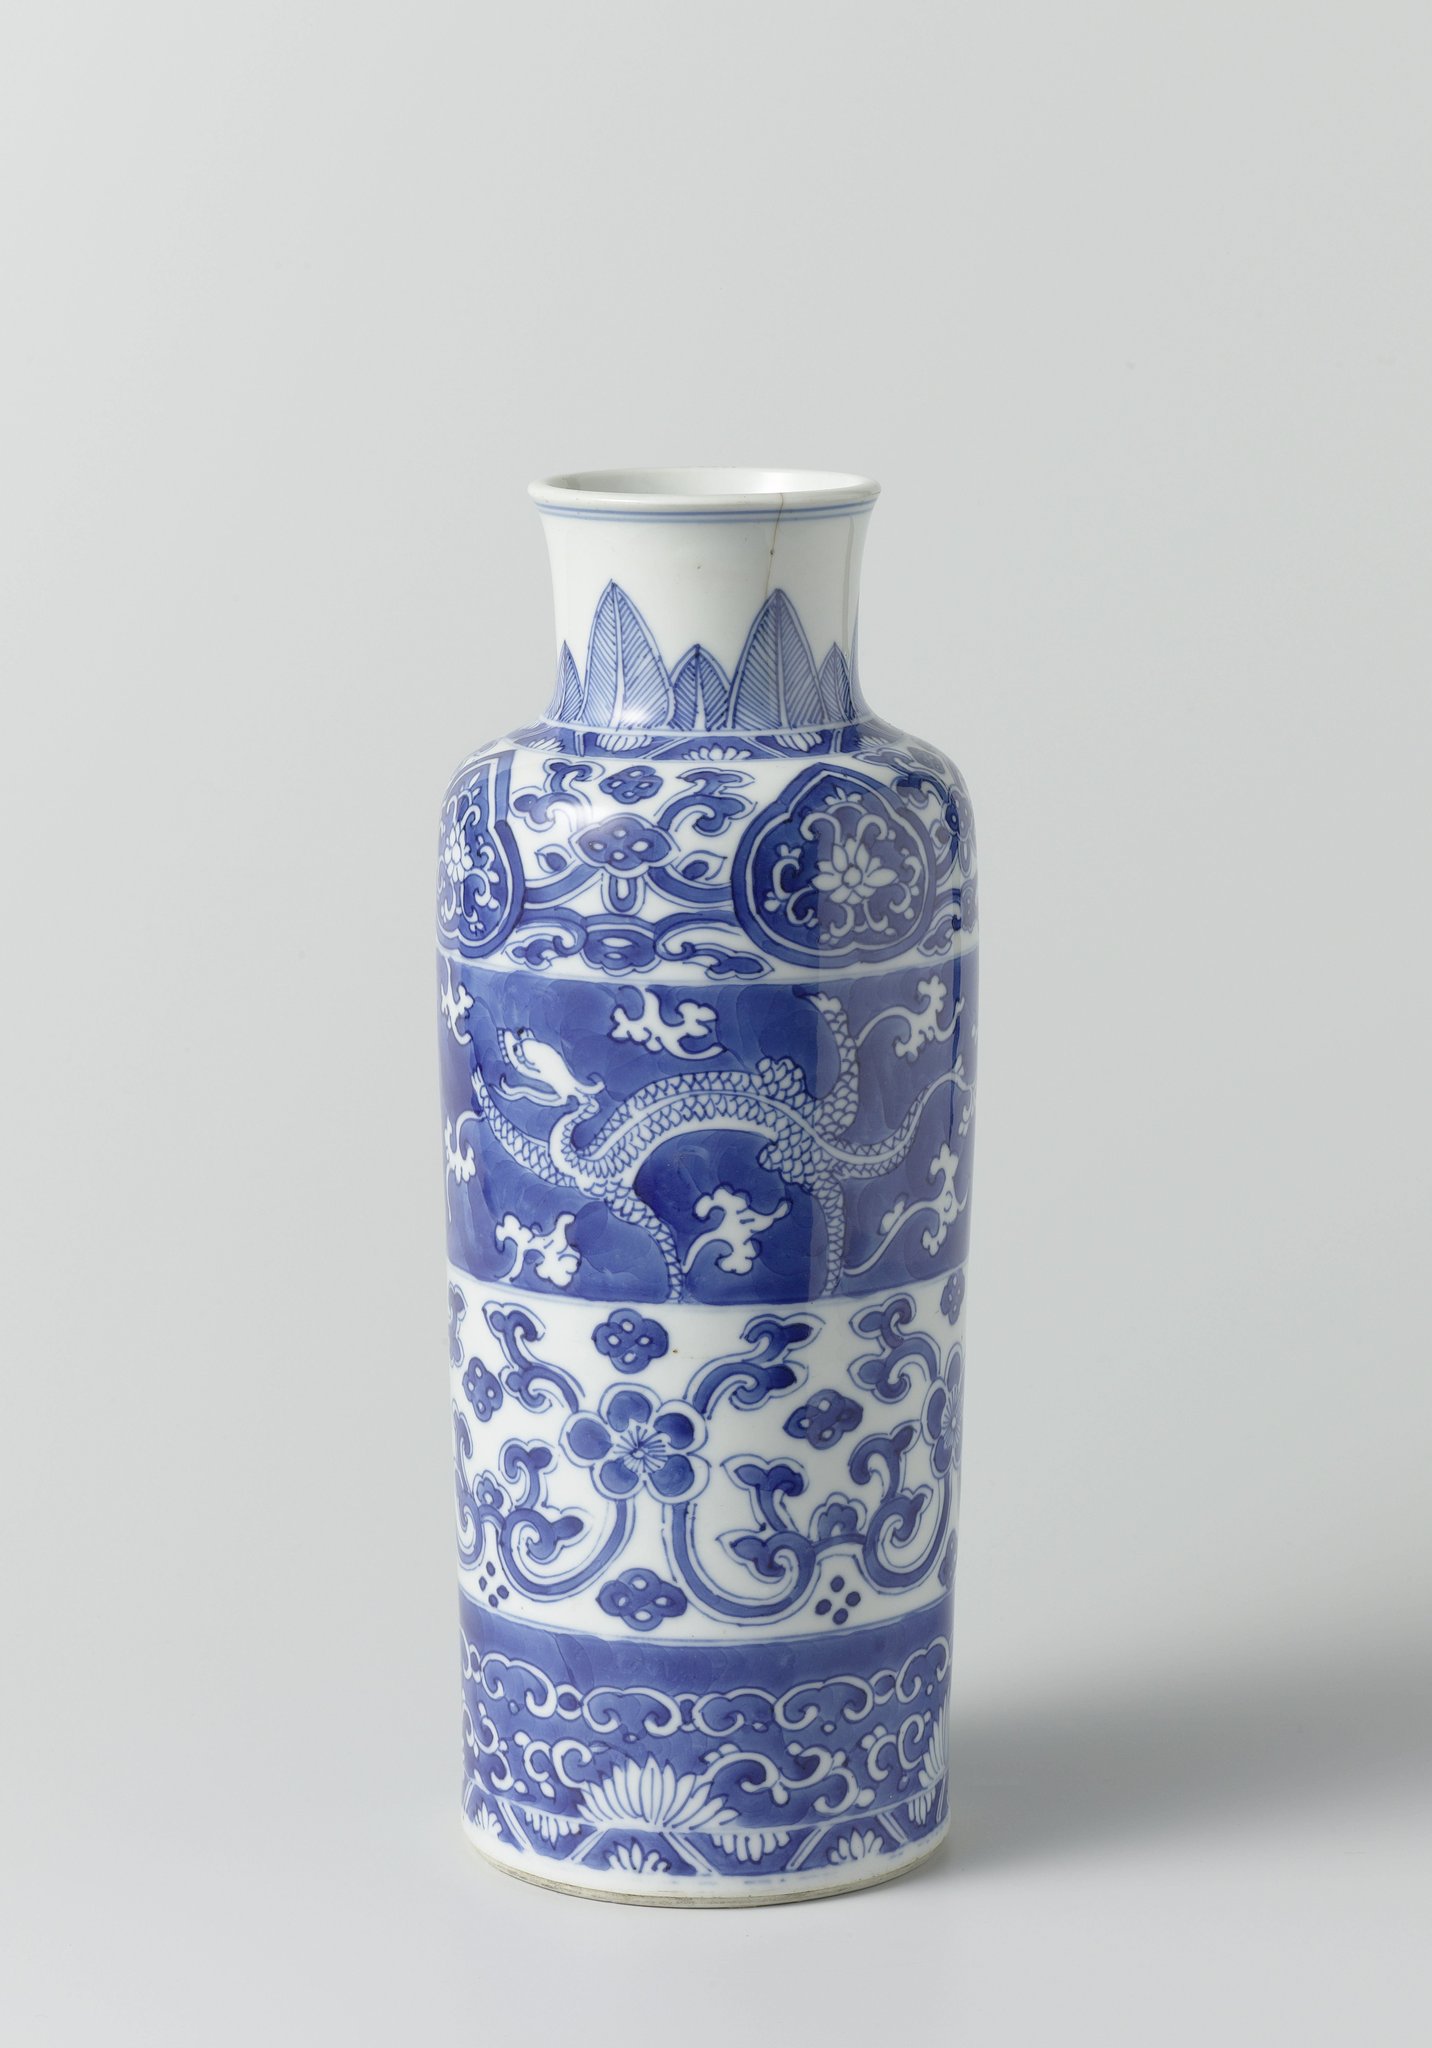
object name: rolwagen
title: Cylindrical vase with dragons and floral scrolls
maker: Anonymous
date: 1700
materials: cobalt, glaze, paint, porcelain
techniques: firing, turning, vitrification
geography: china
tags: ornament ~ arabesque, flowers: lotus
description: Cilindrische vaas van porselein met een wijde, licht spreidende nek, beschilderd in onderglazuur blauw. De buik is verdeeld in vier brede banden met van onder naar boven: een band met uitgespaarde lotusranken, één met bloemranken, één met twee chilongs (hoornloze draak) met een paddenstoel (lingzhi) tussen wolken en één met bloemranken onderbroken door een uitgespaarde lotusrank in een gelobd cartouche. Op de schouder en boven de voet een band met een zigzag-patroon met bloemen. De nek met staande, puntige bladmotieven. Blauw-wit.